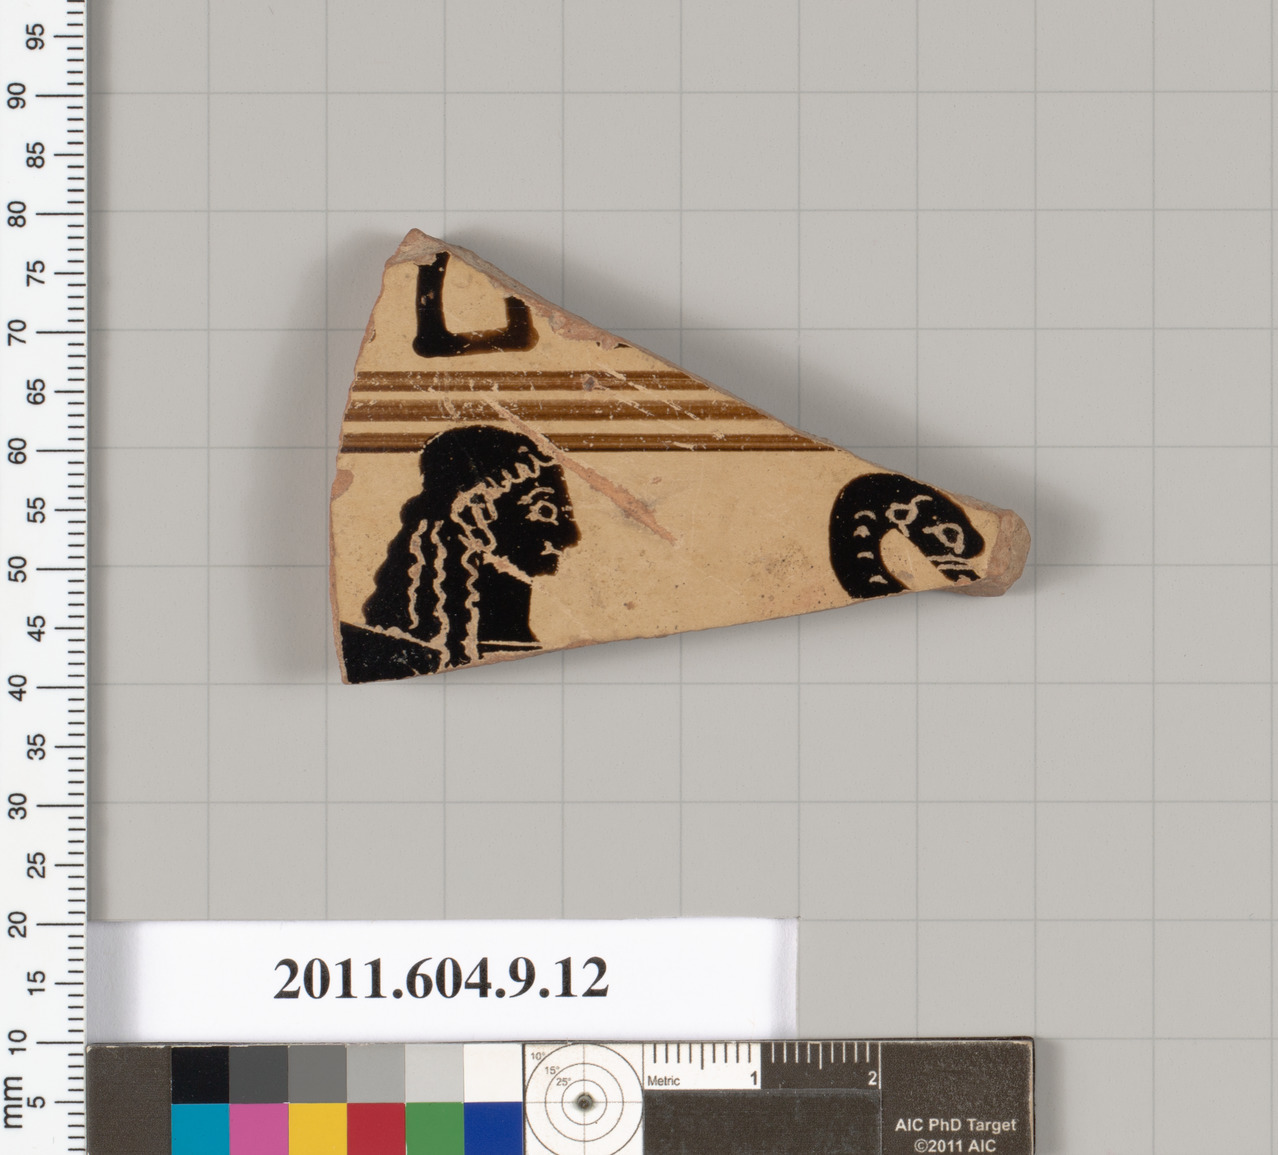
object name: krater fragment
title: Terracotta fragment of a volute-krater?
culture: greek, laconian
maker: hunt painter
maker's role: artist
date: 567-535 BCE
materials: terracotta